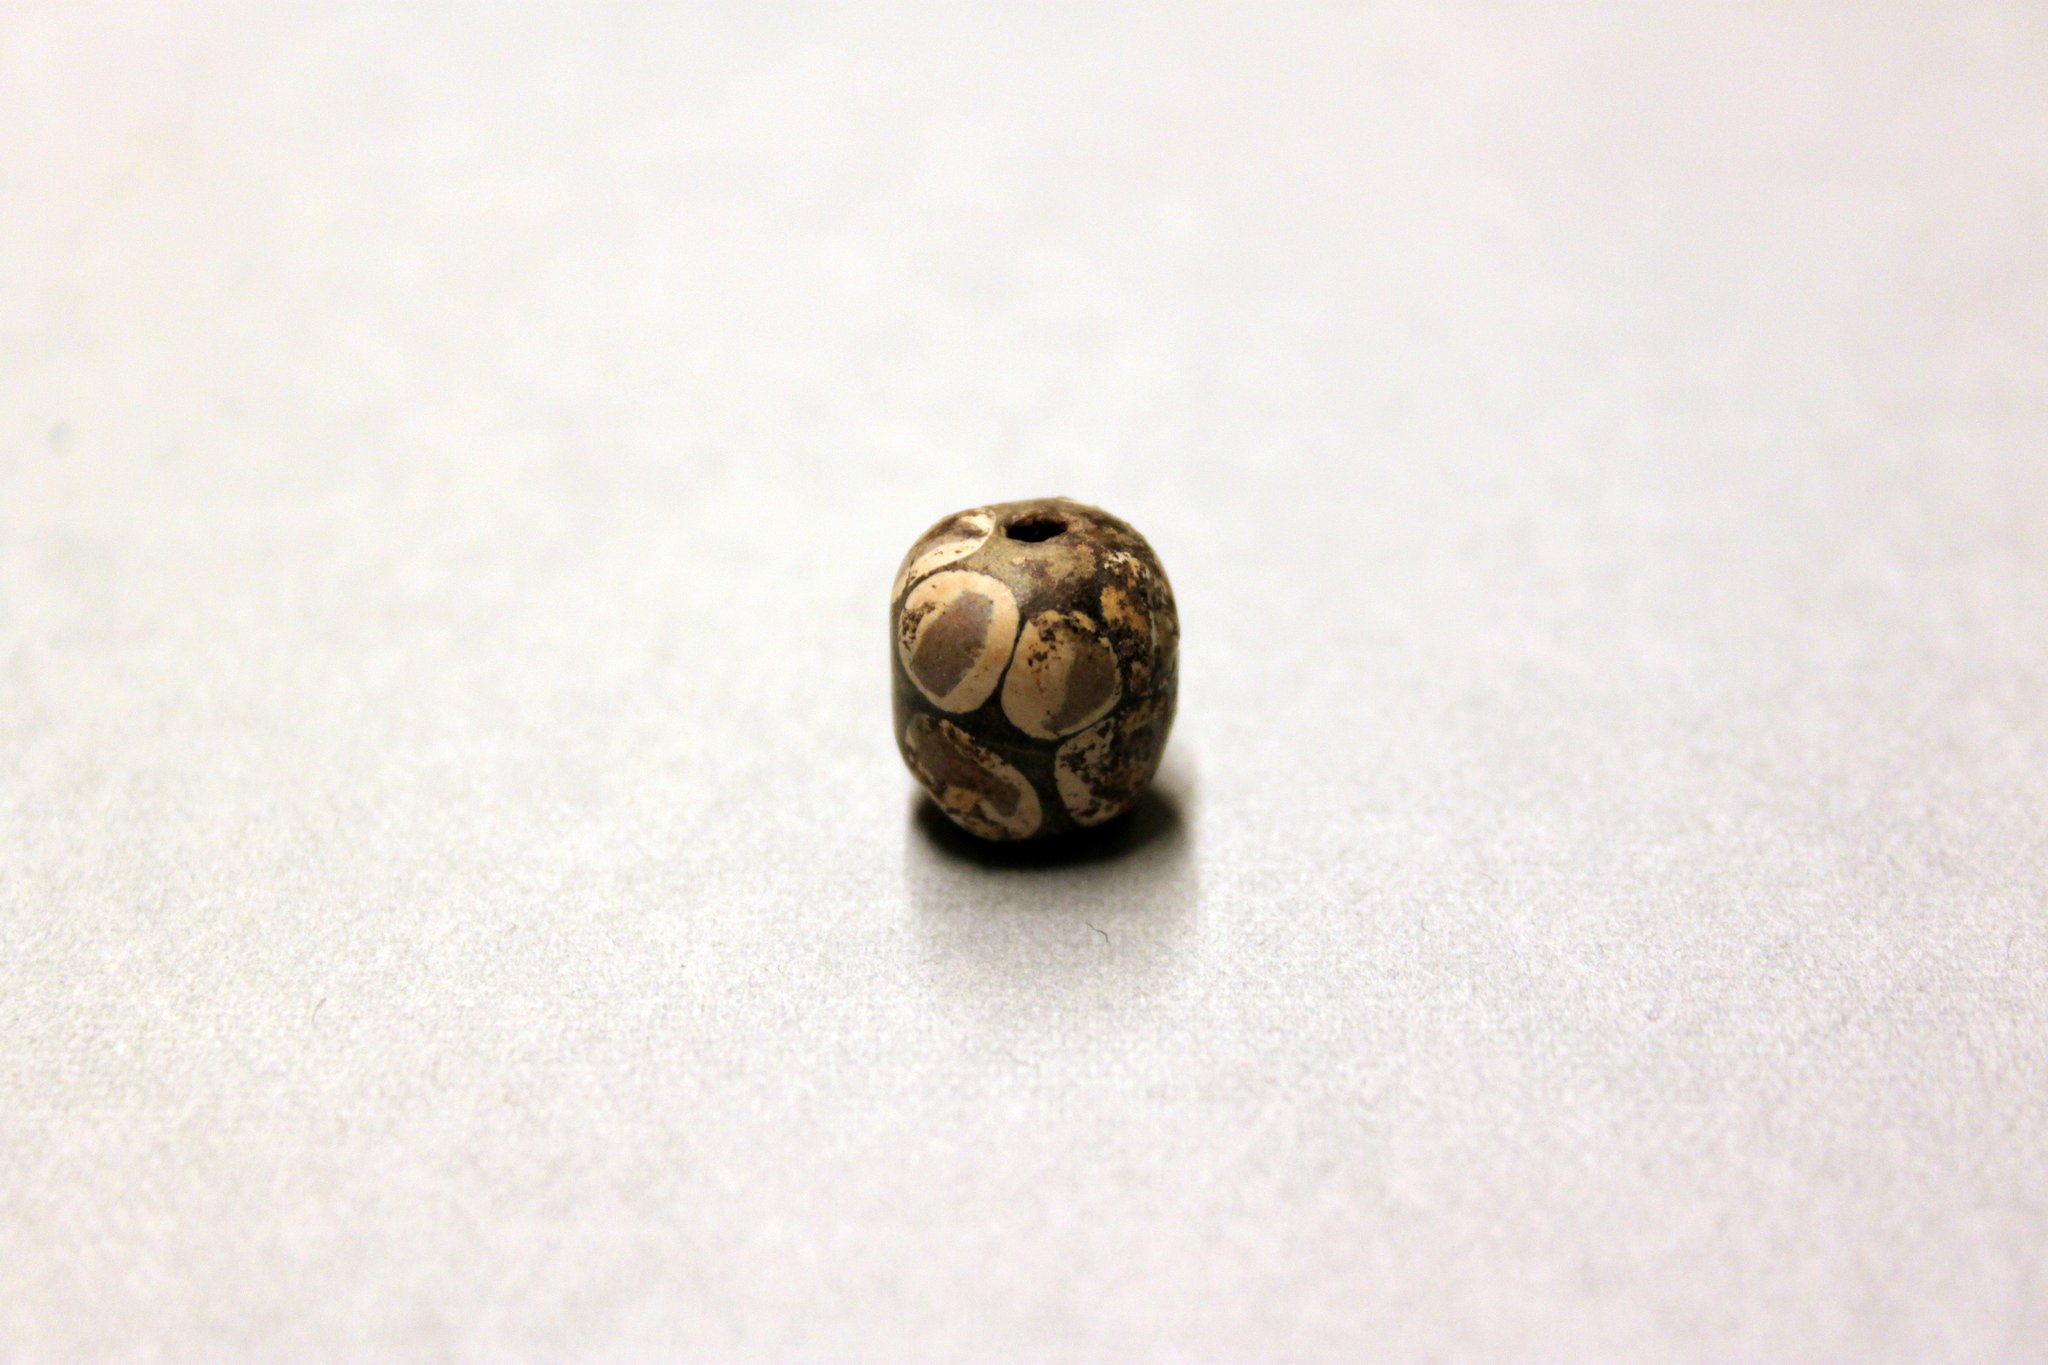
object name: bead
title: Beads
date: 701-1300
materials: glass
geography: iran